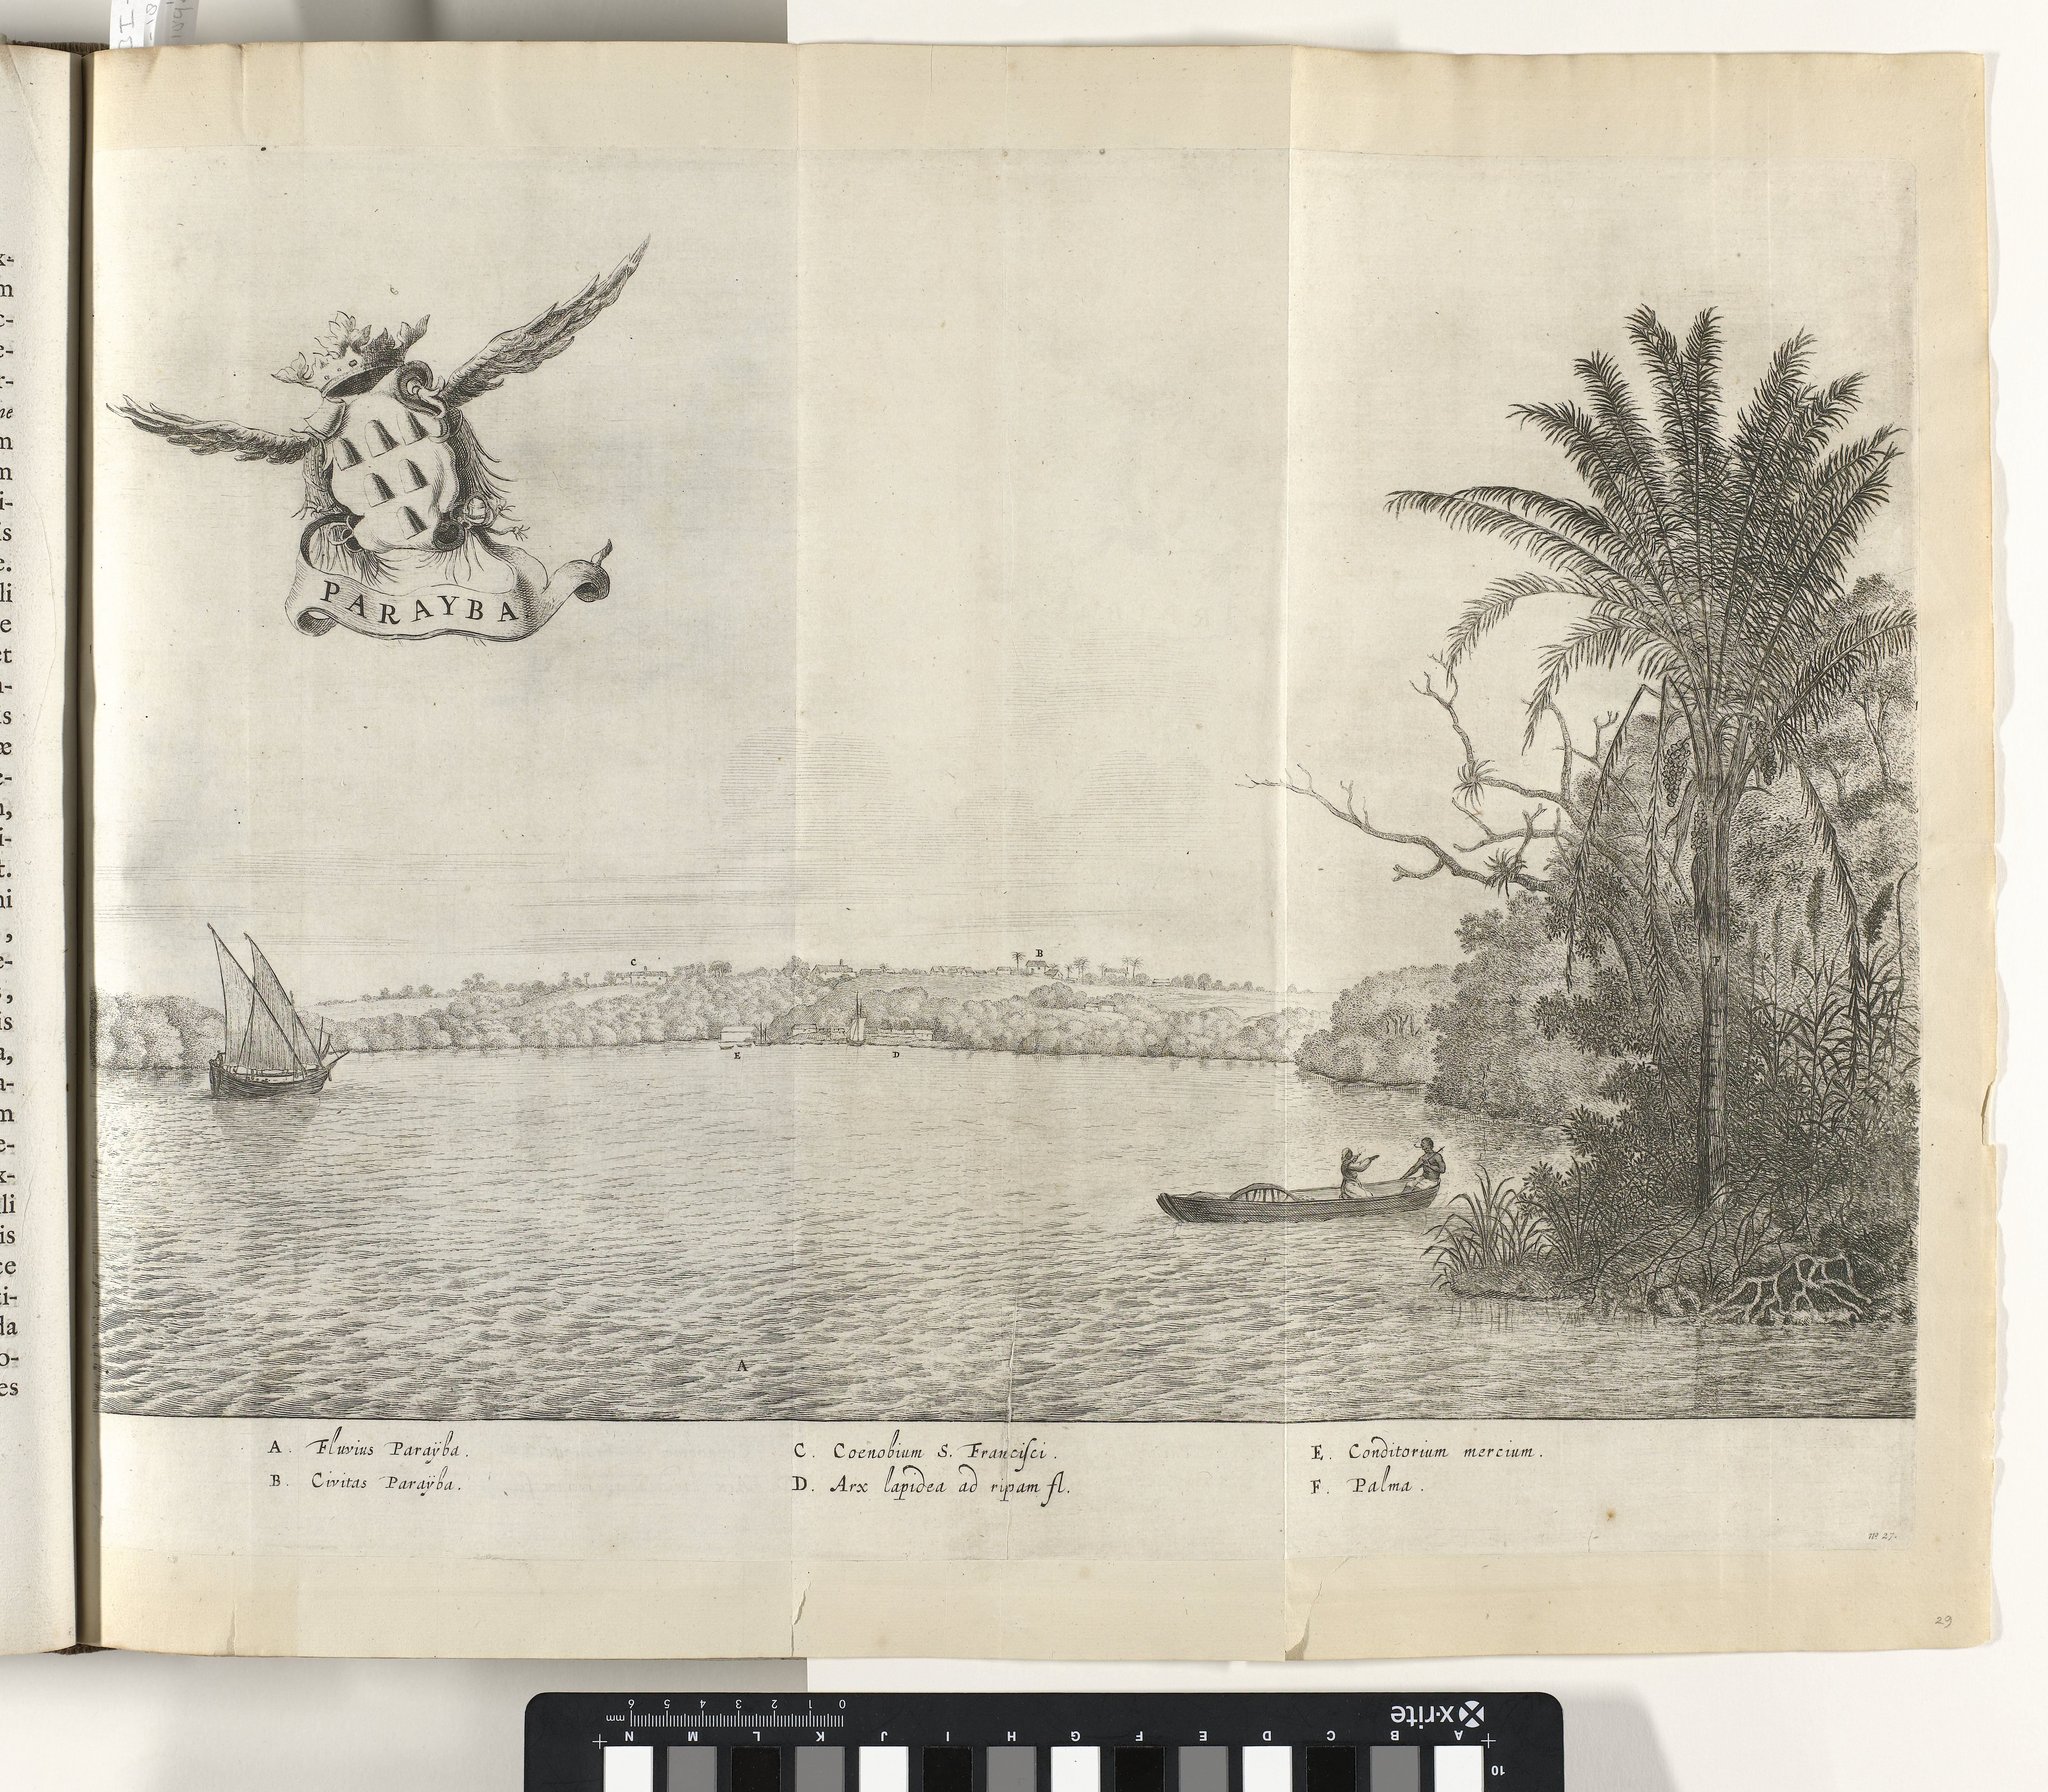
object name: print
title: Gezicht op Paraiba, ca. 1636-1644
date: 1645-1647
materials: paper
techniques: engraving, etching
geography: amsterdam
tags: earl, johan maurits graaf van nassau-siegen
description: Gezicht op de stad Paraiba gelegen aan de rivier Rio Paraiba, ca. 1636-1644. In de lucht een gevleugelde banderol met de titel en een wapen met zes bergen of korven. In het onderschrift de verklaring van de letters A-F in het Latijn. Plaat nr. 27 in een serie van 55 voorstellingen van de tocht naar en het verblijf in Brazilië van graaf Johan Maurits van Nassau in de jaren 1636-1644.